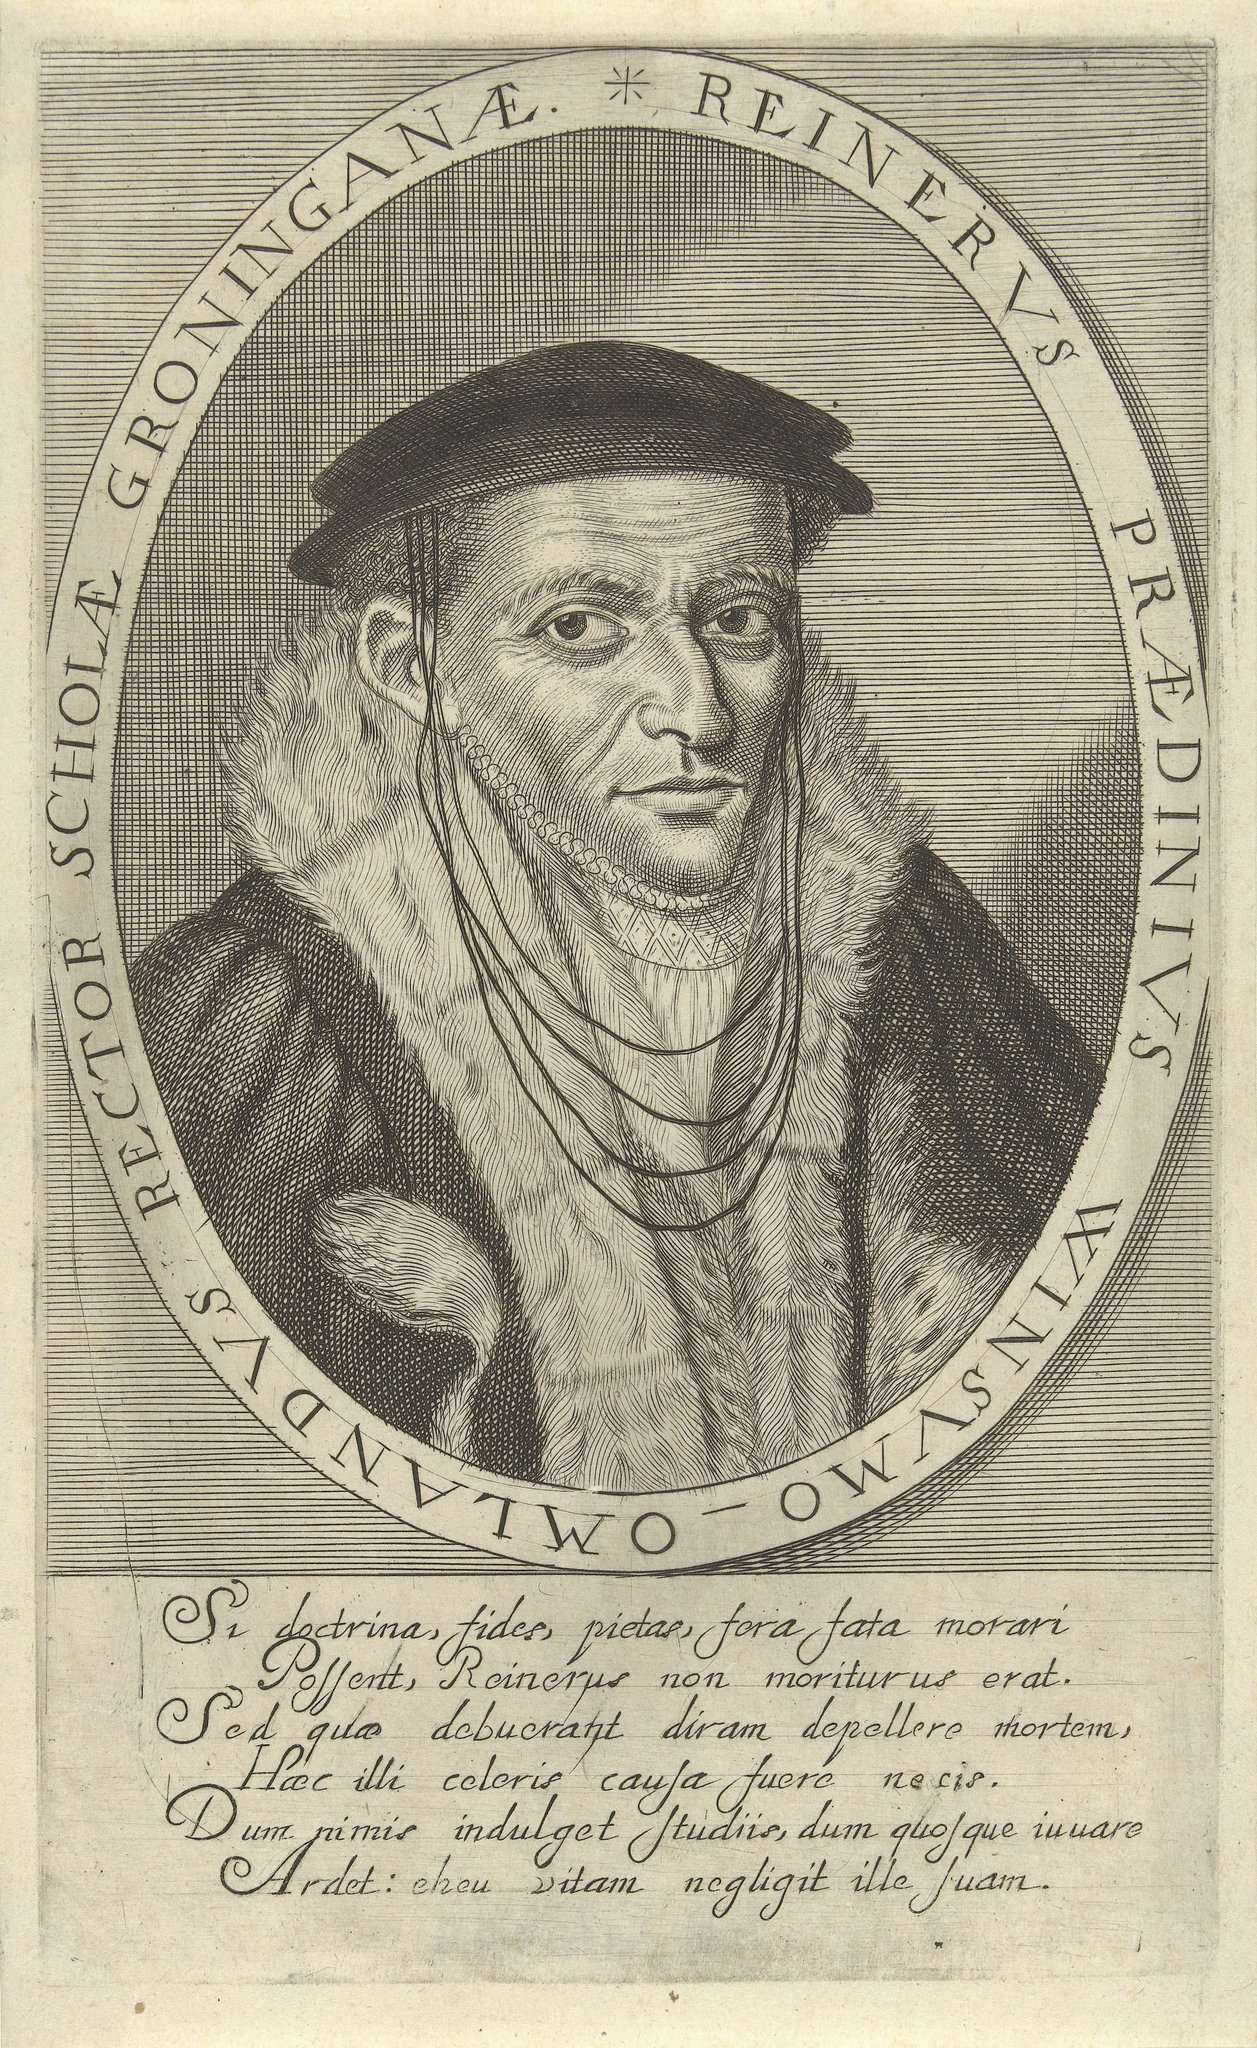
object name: print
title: Portret van Regnerus Praedinius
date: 1654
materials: paper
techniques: engraving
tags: rector, regnerus praedinius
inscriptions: collector's mark: Lugt 2228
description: Portretbuste in ovaal naar rechts van Regnerus Praedinius, rector der Latijnse scholen te Groningen, met hoofddeksel. Op de ovale omlijsting staat een randschrift in Latijn, in de marge een zesregelig Latijns vers.